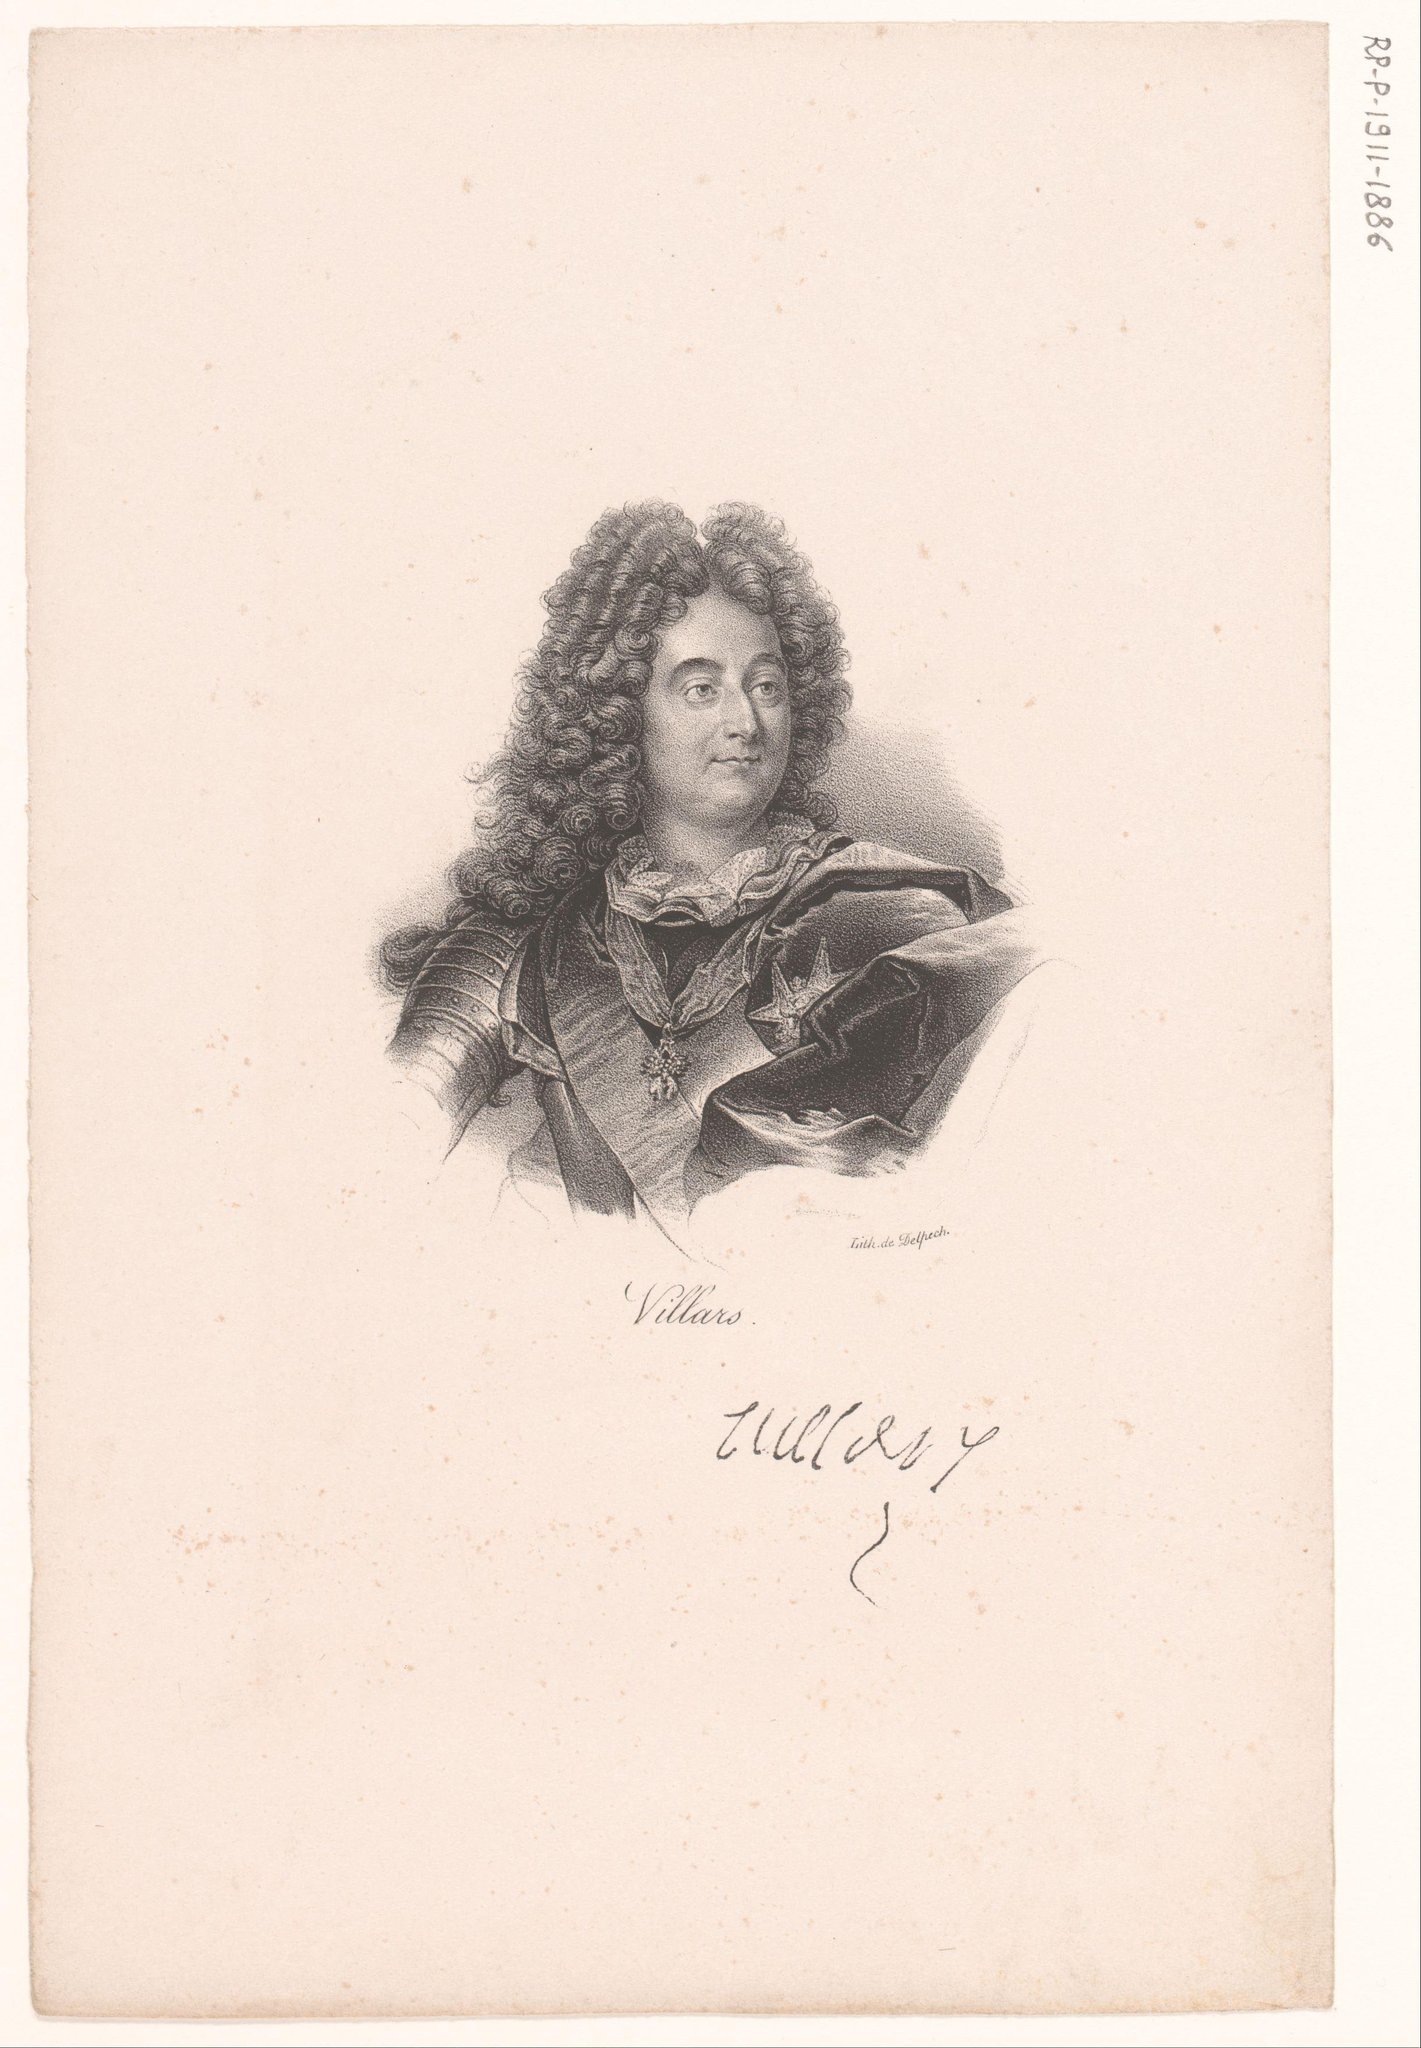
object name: print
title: Villars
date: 1818-1842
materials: paper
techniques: lithograph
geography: paris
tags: historical persons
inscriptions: collector's mark: Lugt 2228a